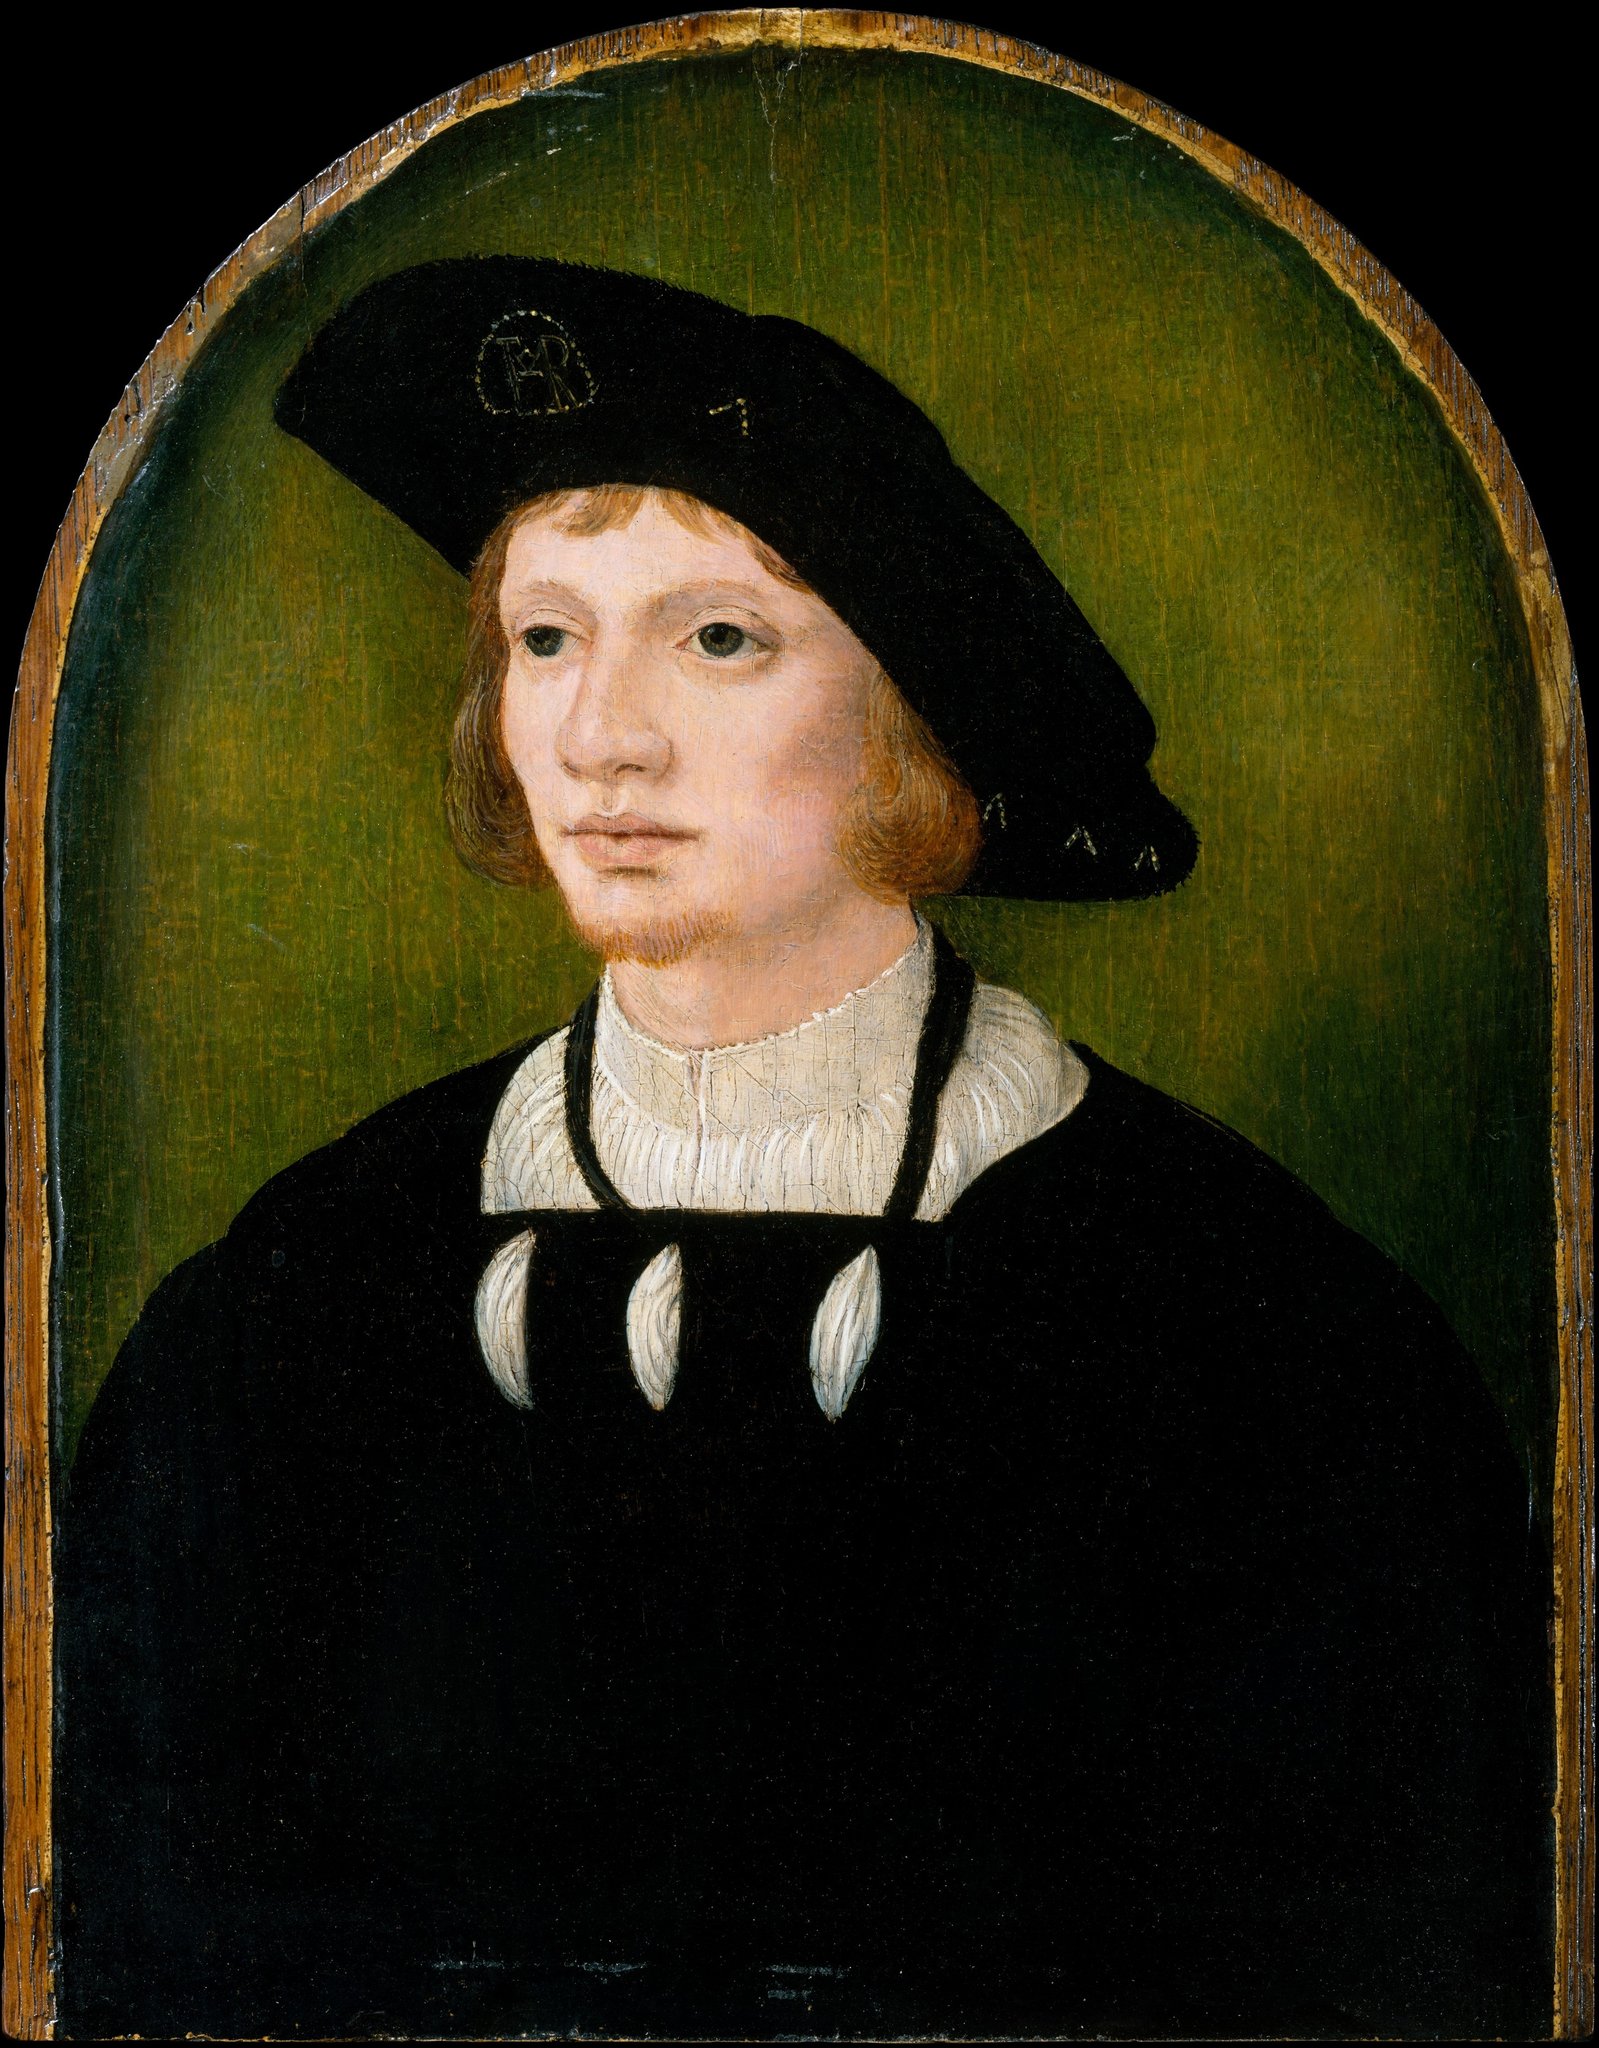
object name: painting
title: Portrait of a Man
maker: netherlandish painter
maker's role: artist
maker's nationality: netherlandish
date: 1500-1549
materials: oil, wood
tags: men,portraits